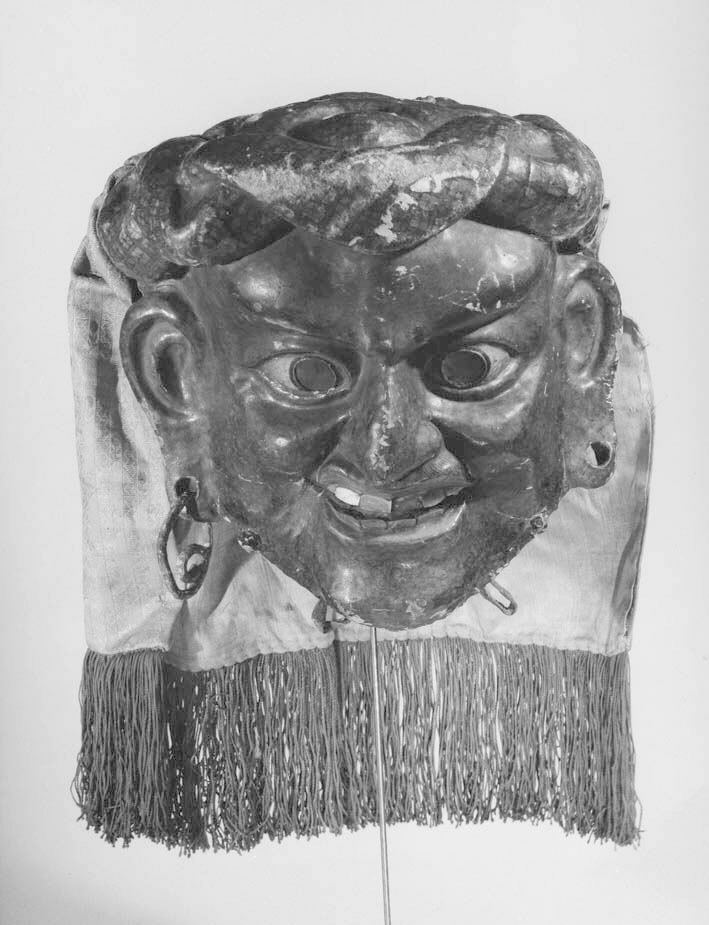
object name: mask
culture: tibetan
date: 1867-1900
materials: textile, paper, varnish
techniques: painting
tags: masks